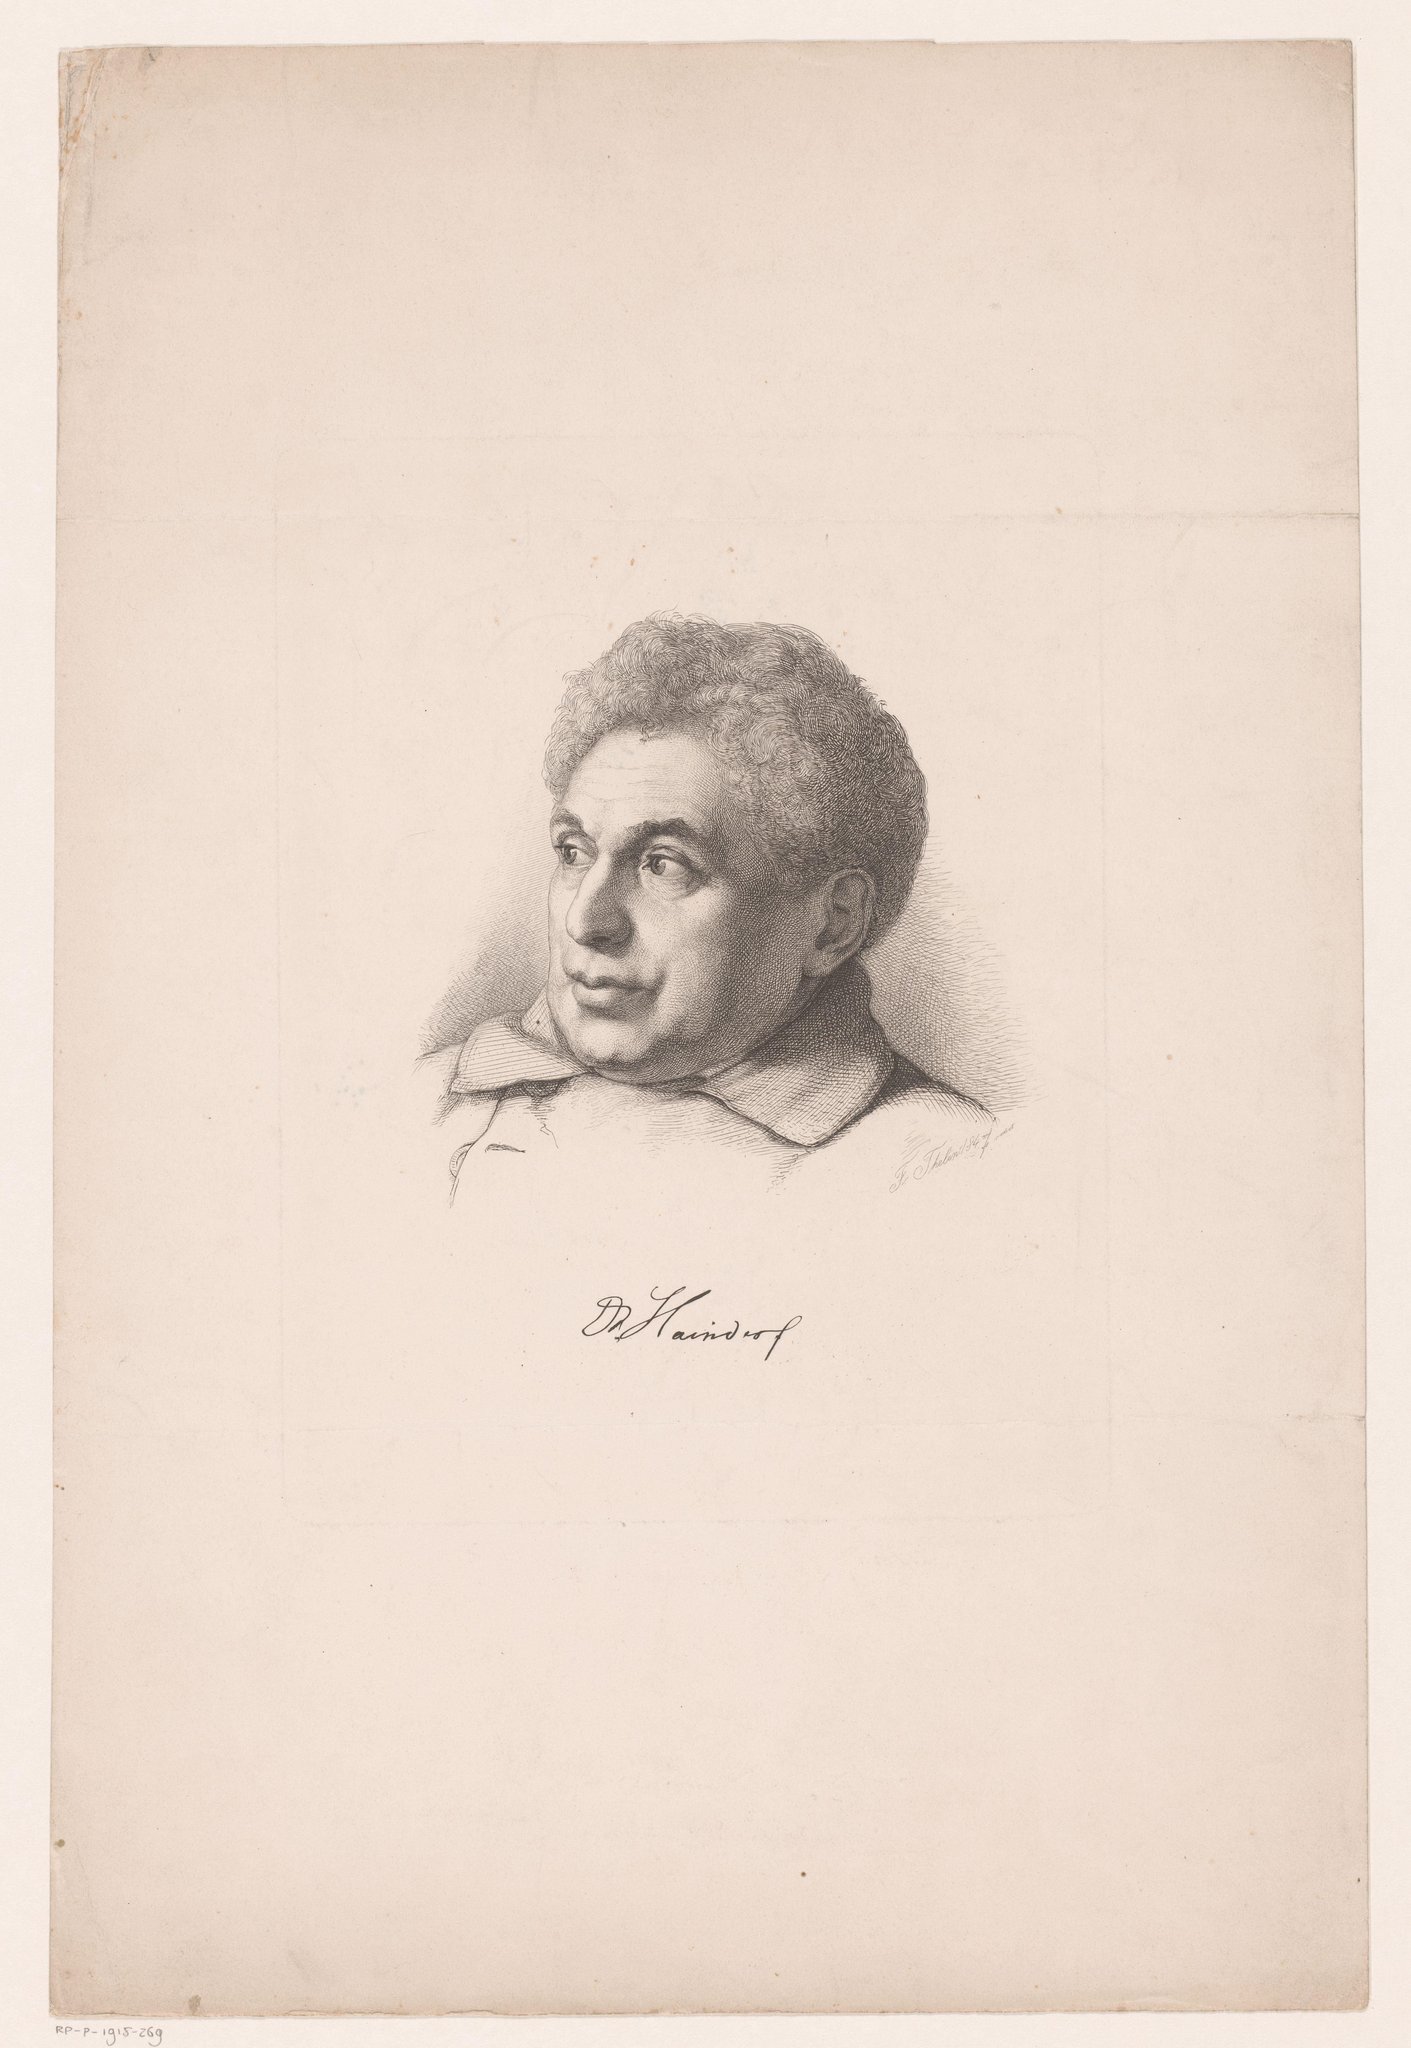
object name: print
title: Portret van Alexander Haindorf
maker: franz thelen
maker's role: print maker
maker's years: 1826-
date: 1847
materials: paper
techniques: etching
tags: historical persons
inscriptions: collector's mark: Lugt 2228